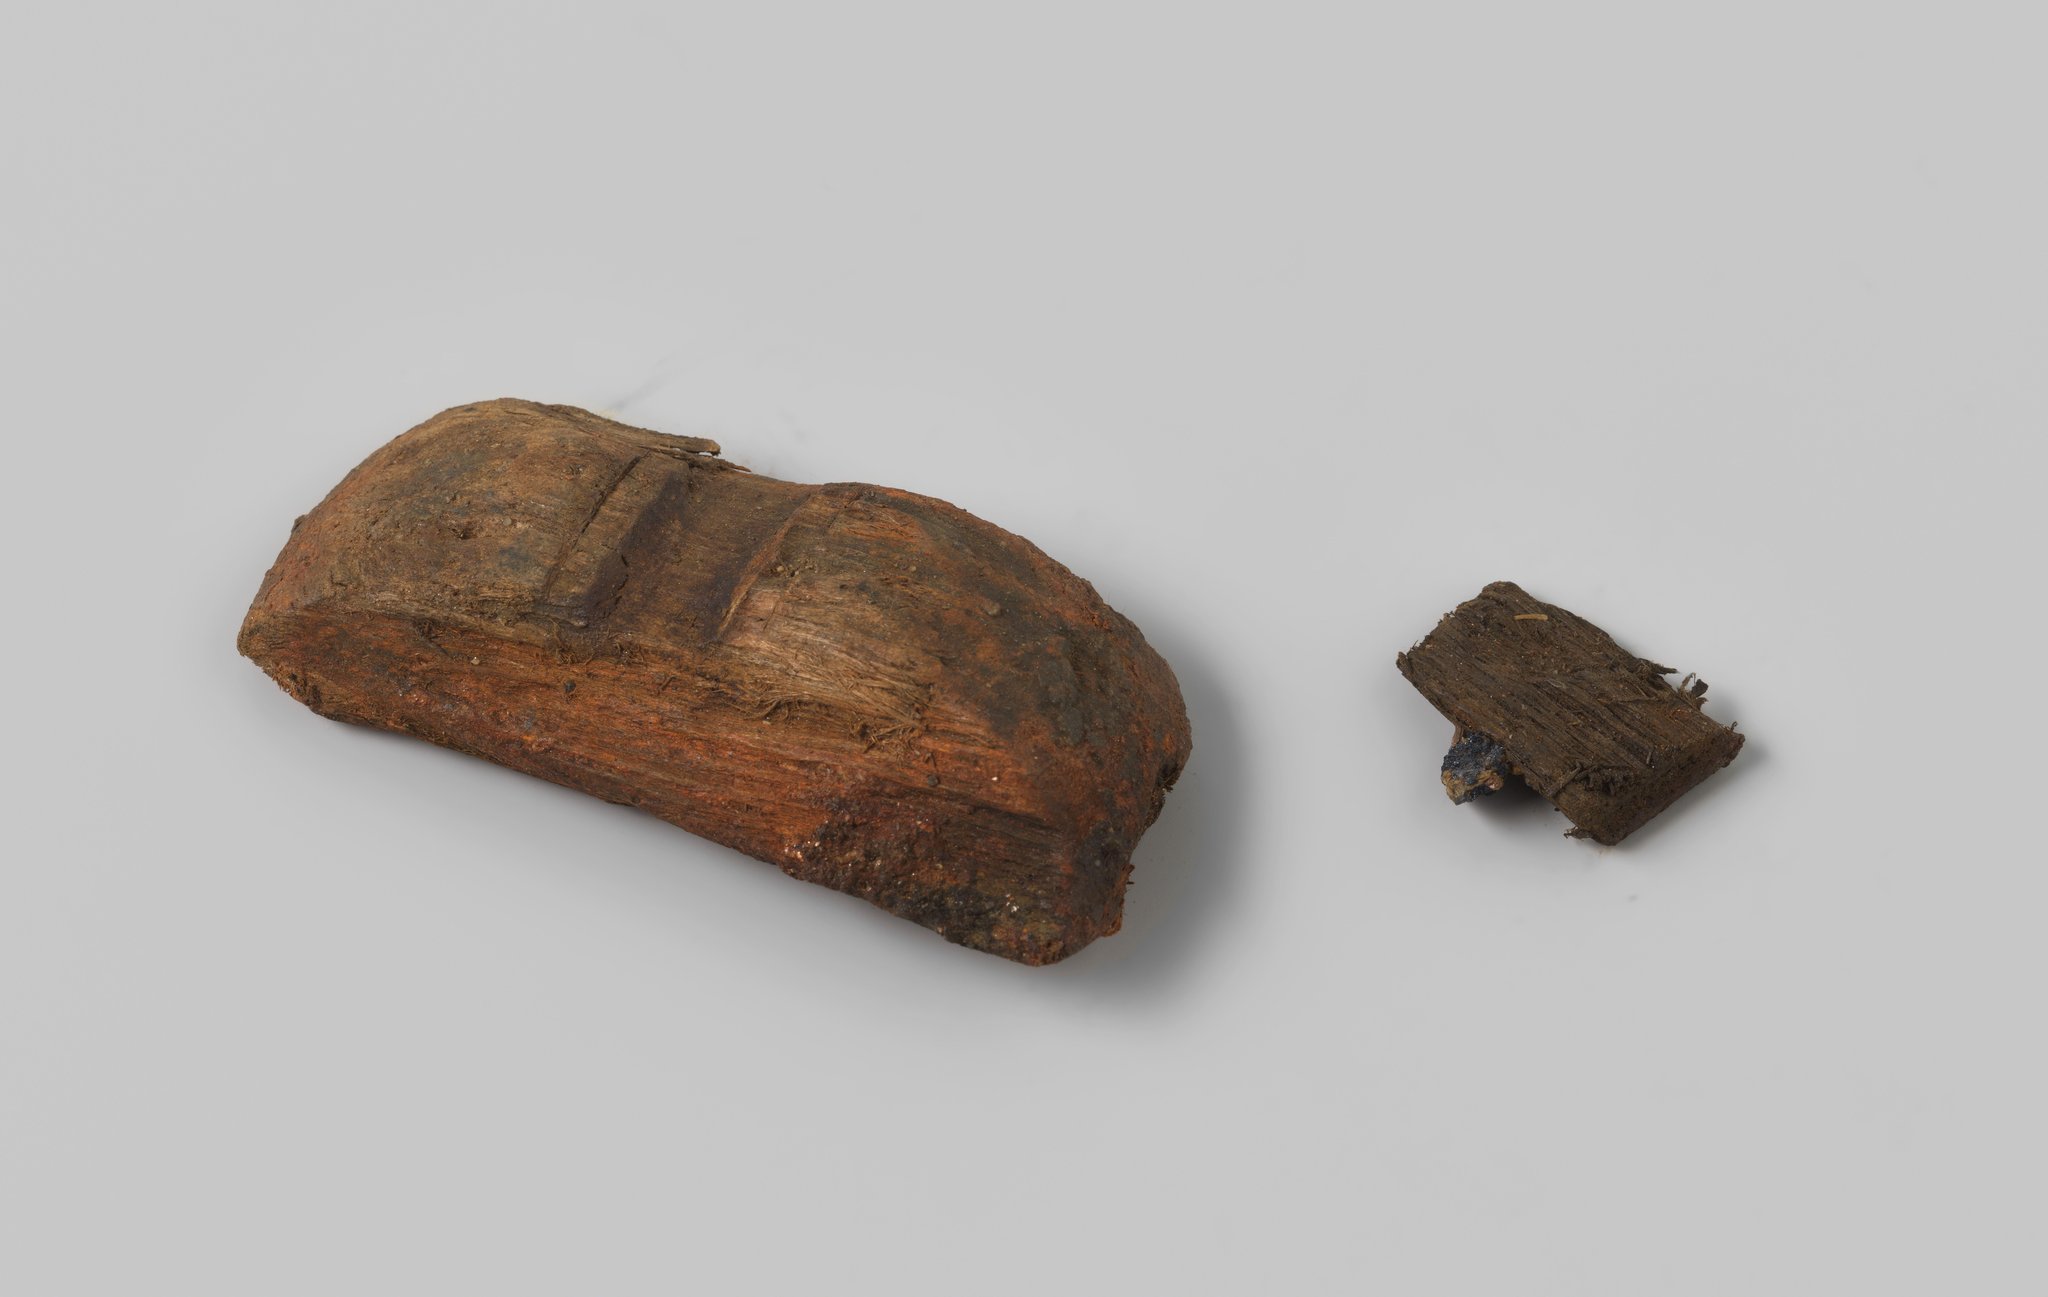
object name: wantklootje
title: Fragmenten wantklootjes uit het wrak van de Oost-Indiëvaarder Hollandia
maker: Anonymous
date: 1700-1743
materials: wood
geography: netherlands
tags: verenigde oostindische compagnie, hollandia (schip), annet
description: Bead, shroudtruck; fragm, id. NG 1979-253H2250.